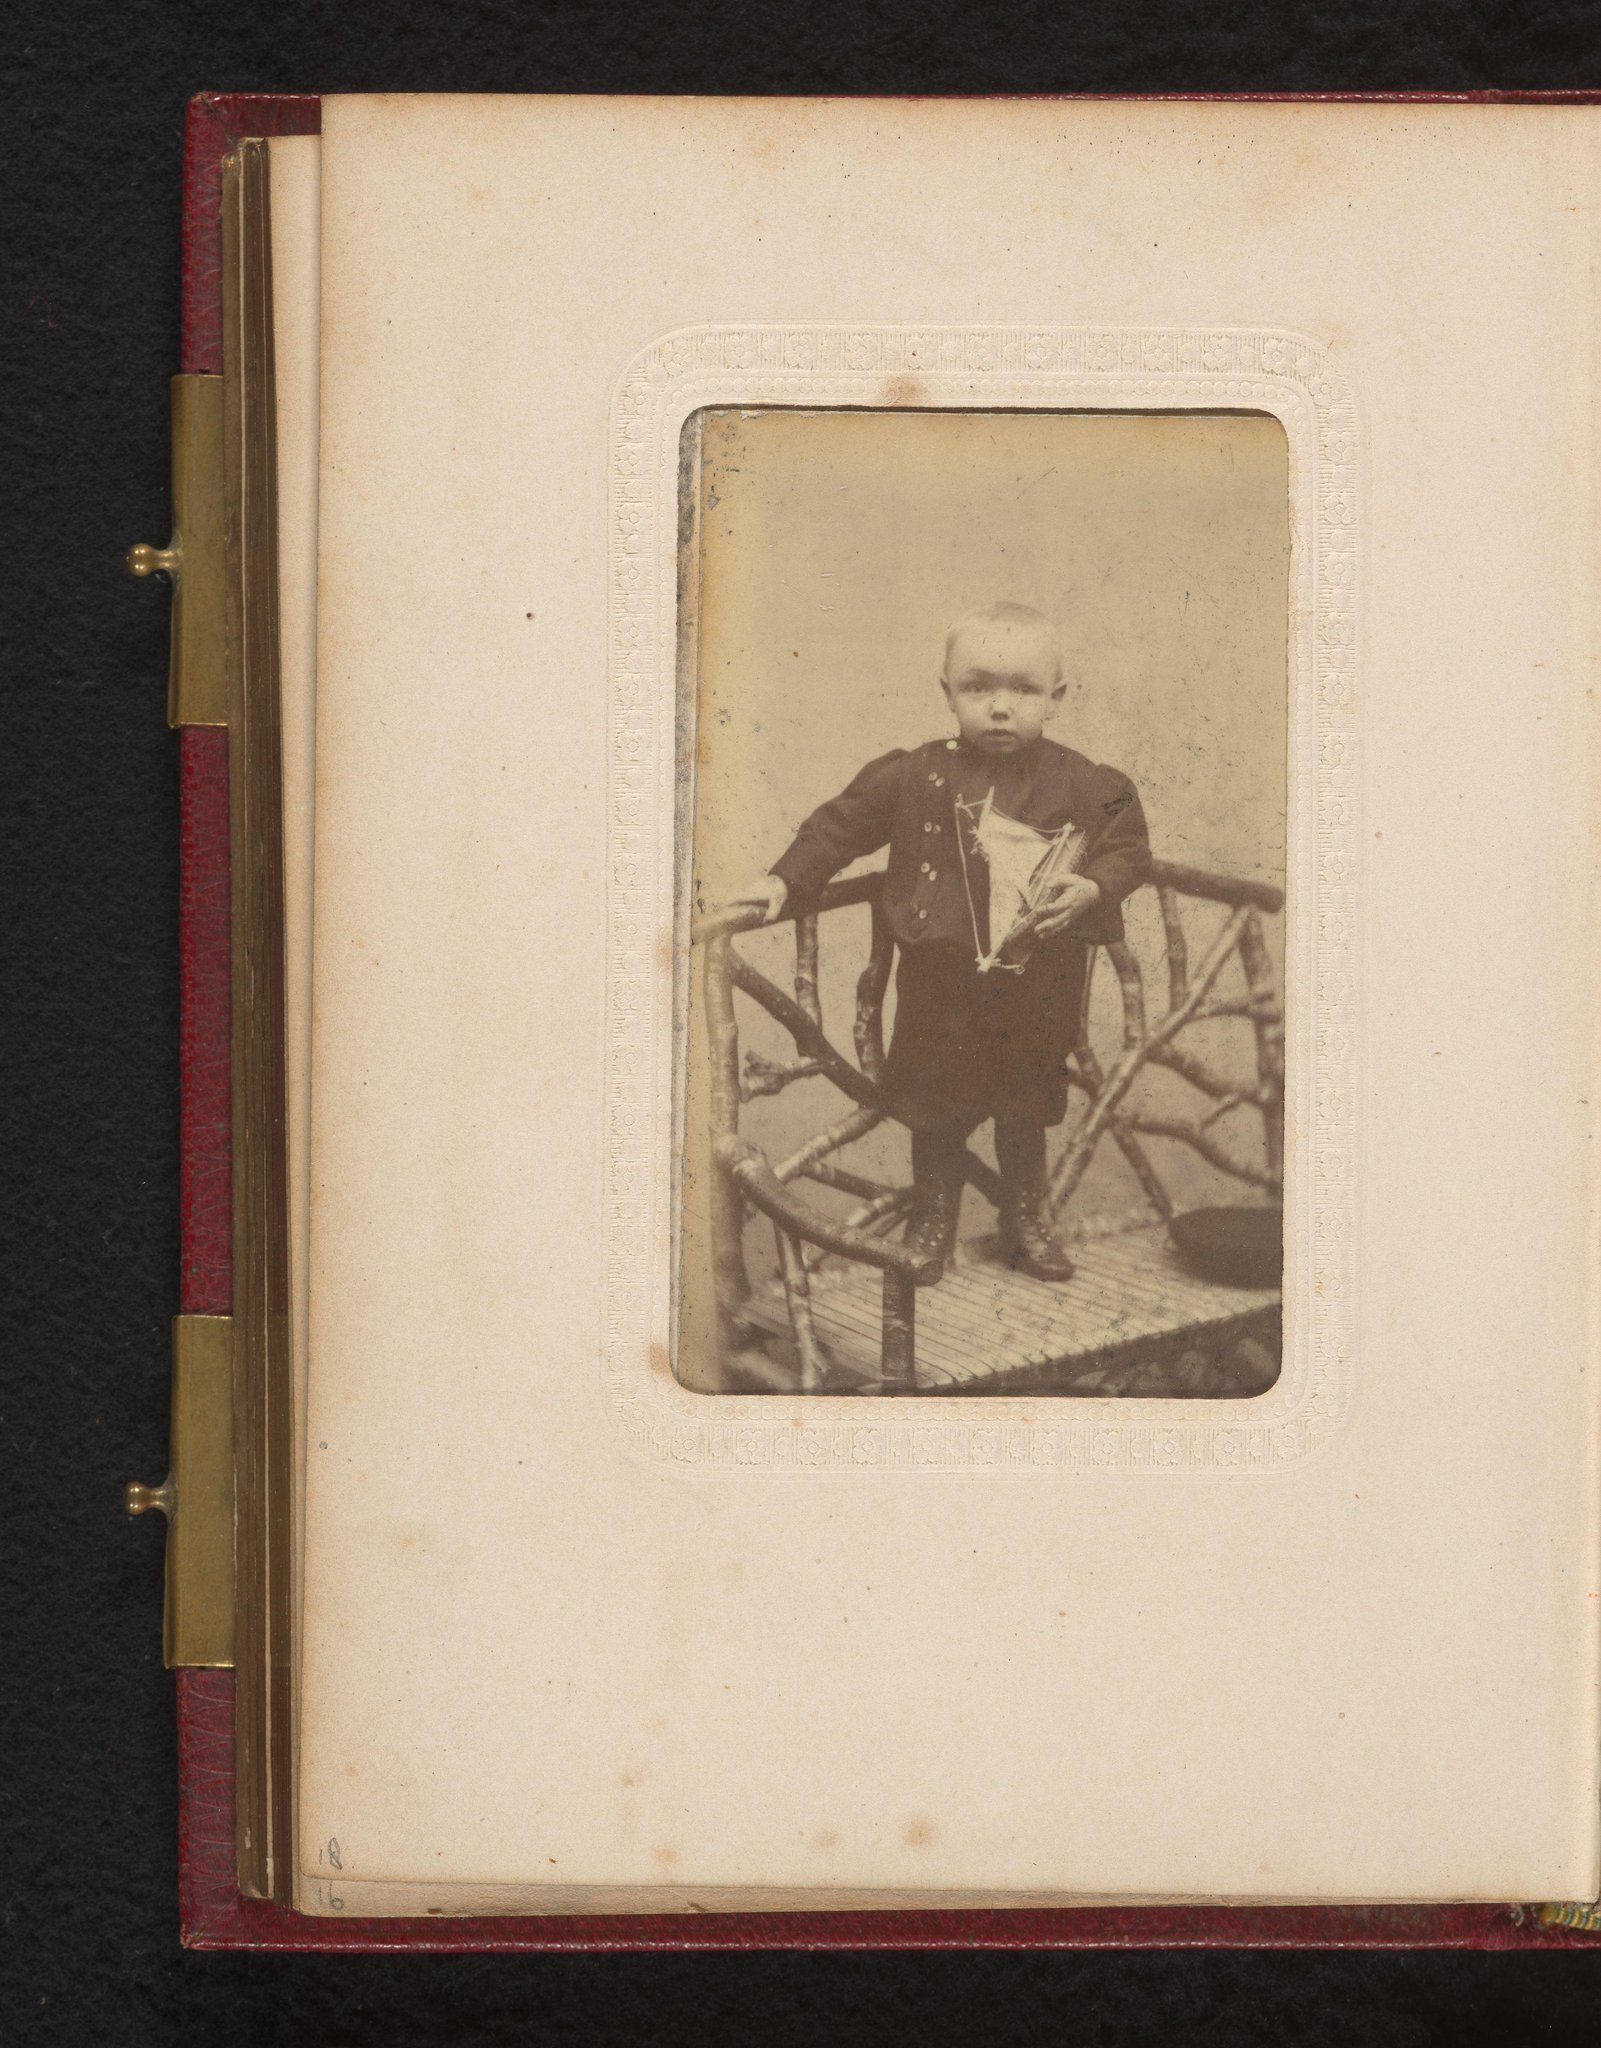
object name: album leaf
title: Portret van een peuter, staand op een bank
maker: hermanus jodocus weesing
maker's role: fotograaf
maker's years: 1844-1910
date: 1868-1900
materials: cardboard, celluloid, photographic support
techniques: albumen print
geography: amsterdam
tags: bench, historical persons, toddler (male)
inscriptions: inscription: ‘H. J./ Weesing,/ PHOTOGRAPHE/ Amsterdam’